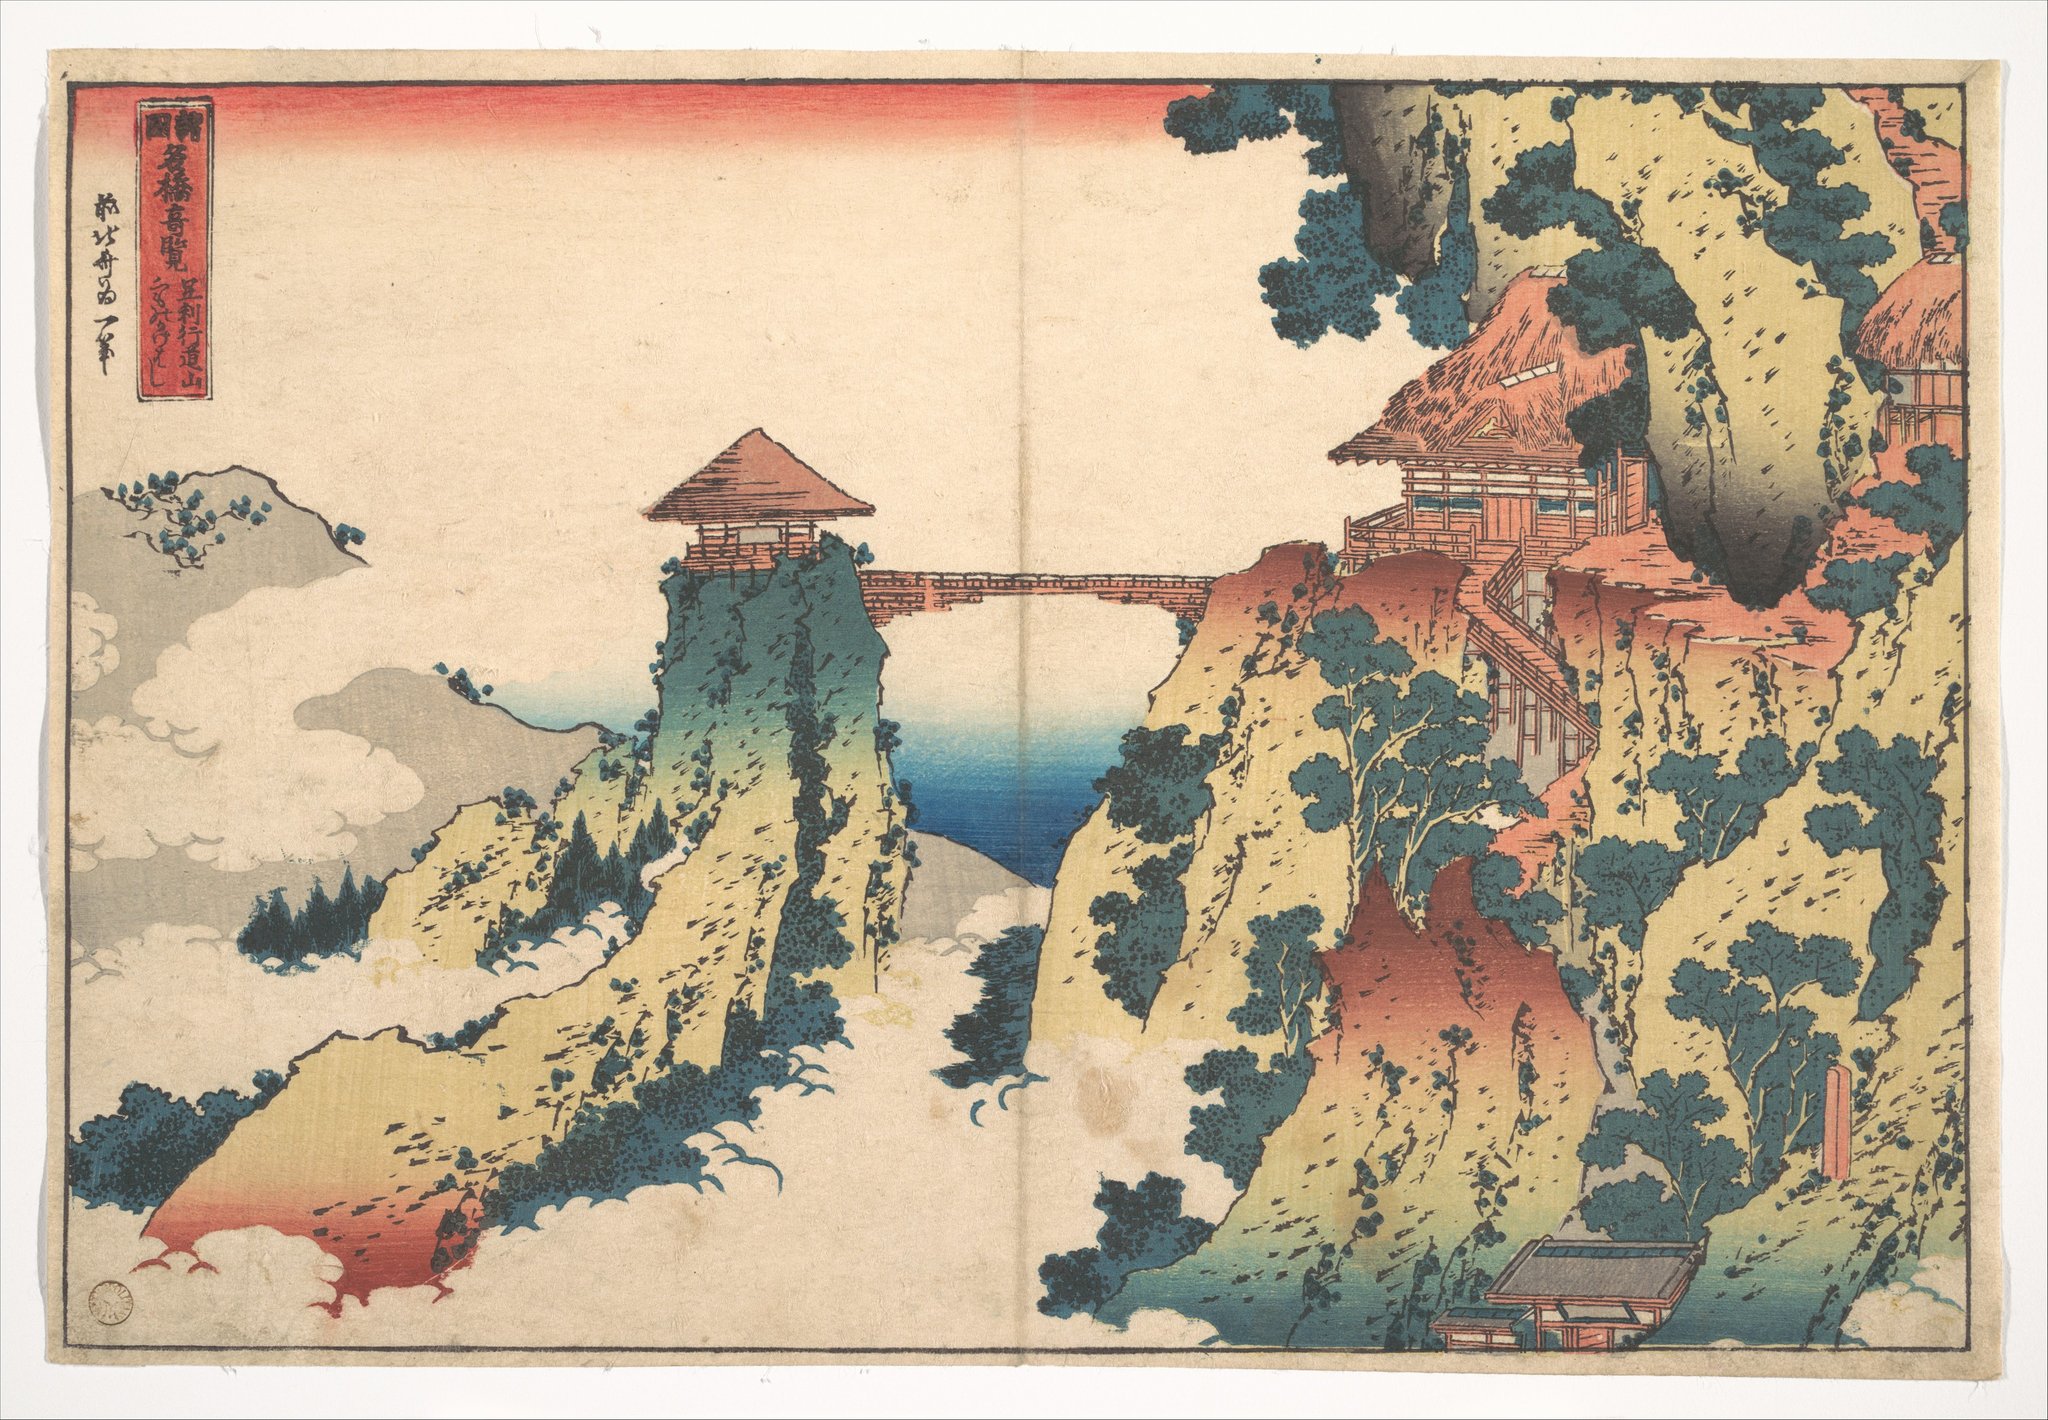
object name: woodblock print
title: The Hanging-cloud Bridge at Mount Gyōdō near Ashikaga (Ashikaga Gyōdōzan kumo no kakehashi), from the series Remarkable Views of Bridges in Various Provinces (Shokoku meikyō kiran)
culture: japanese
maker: katsushika hokusai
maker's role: artist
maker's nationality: japanese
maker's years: 1760-1849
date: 1830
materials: ink, paper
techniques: woodblock print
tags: houses,bridges,mountains,trees